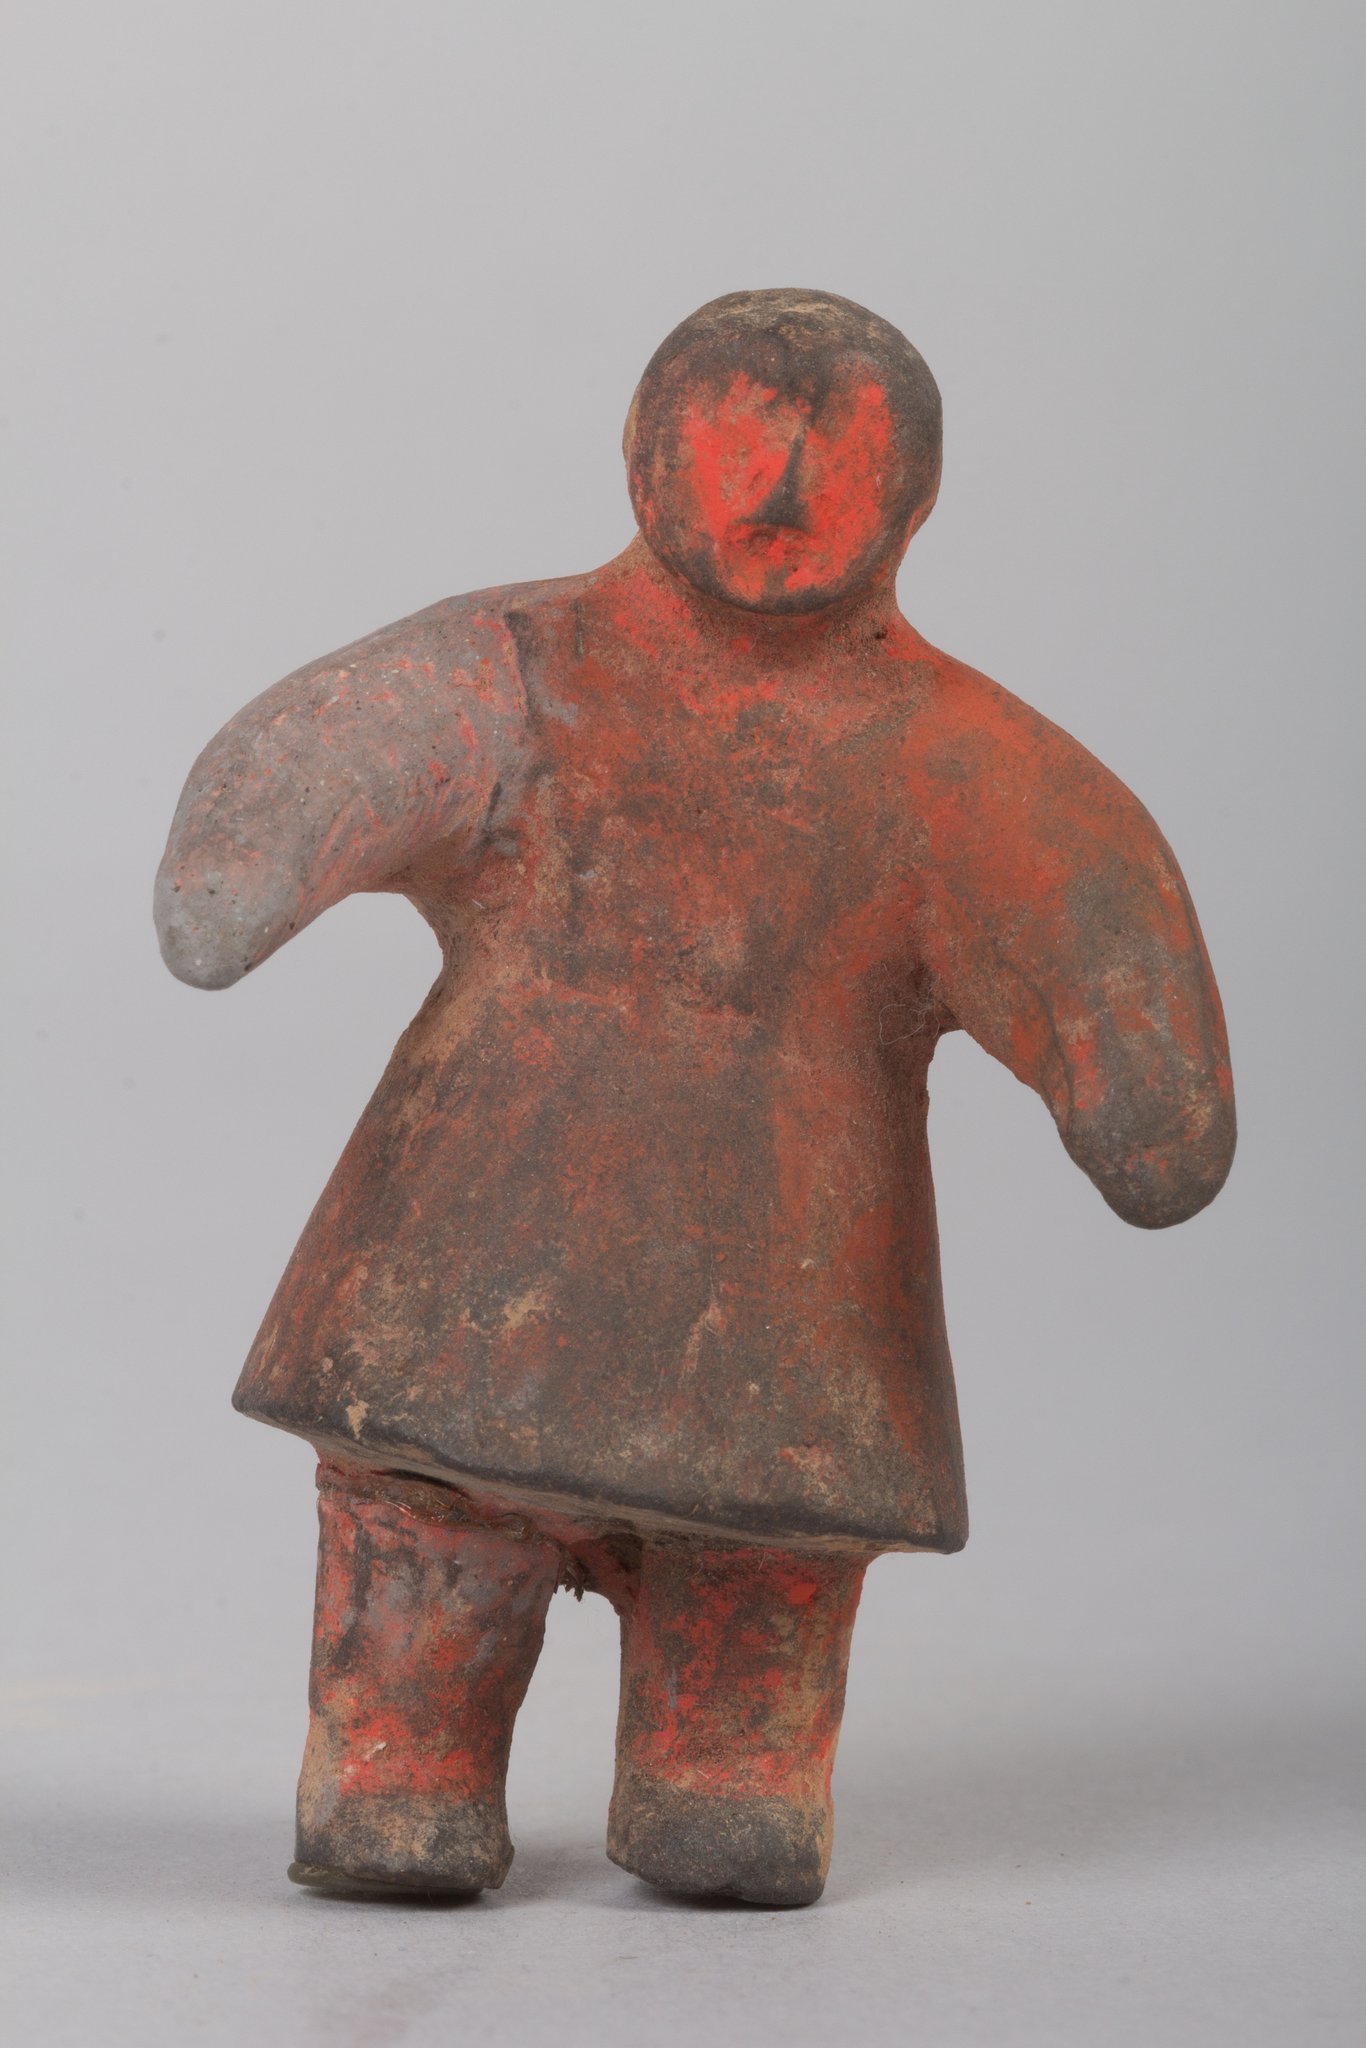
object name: figure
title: Figure of a child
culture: chinese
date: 770-256 BCE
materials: clay